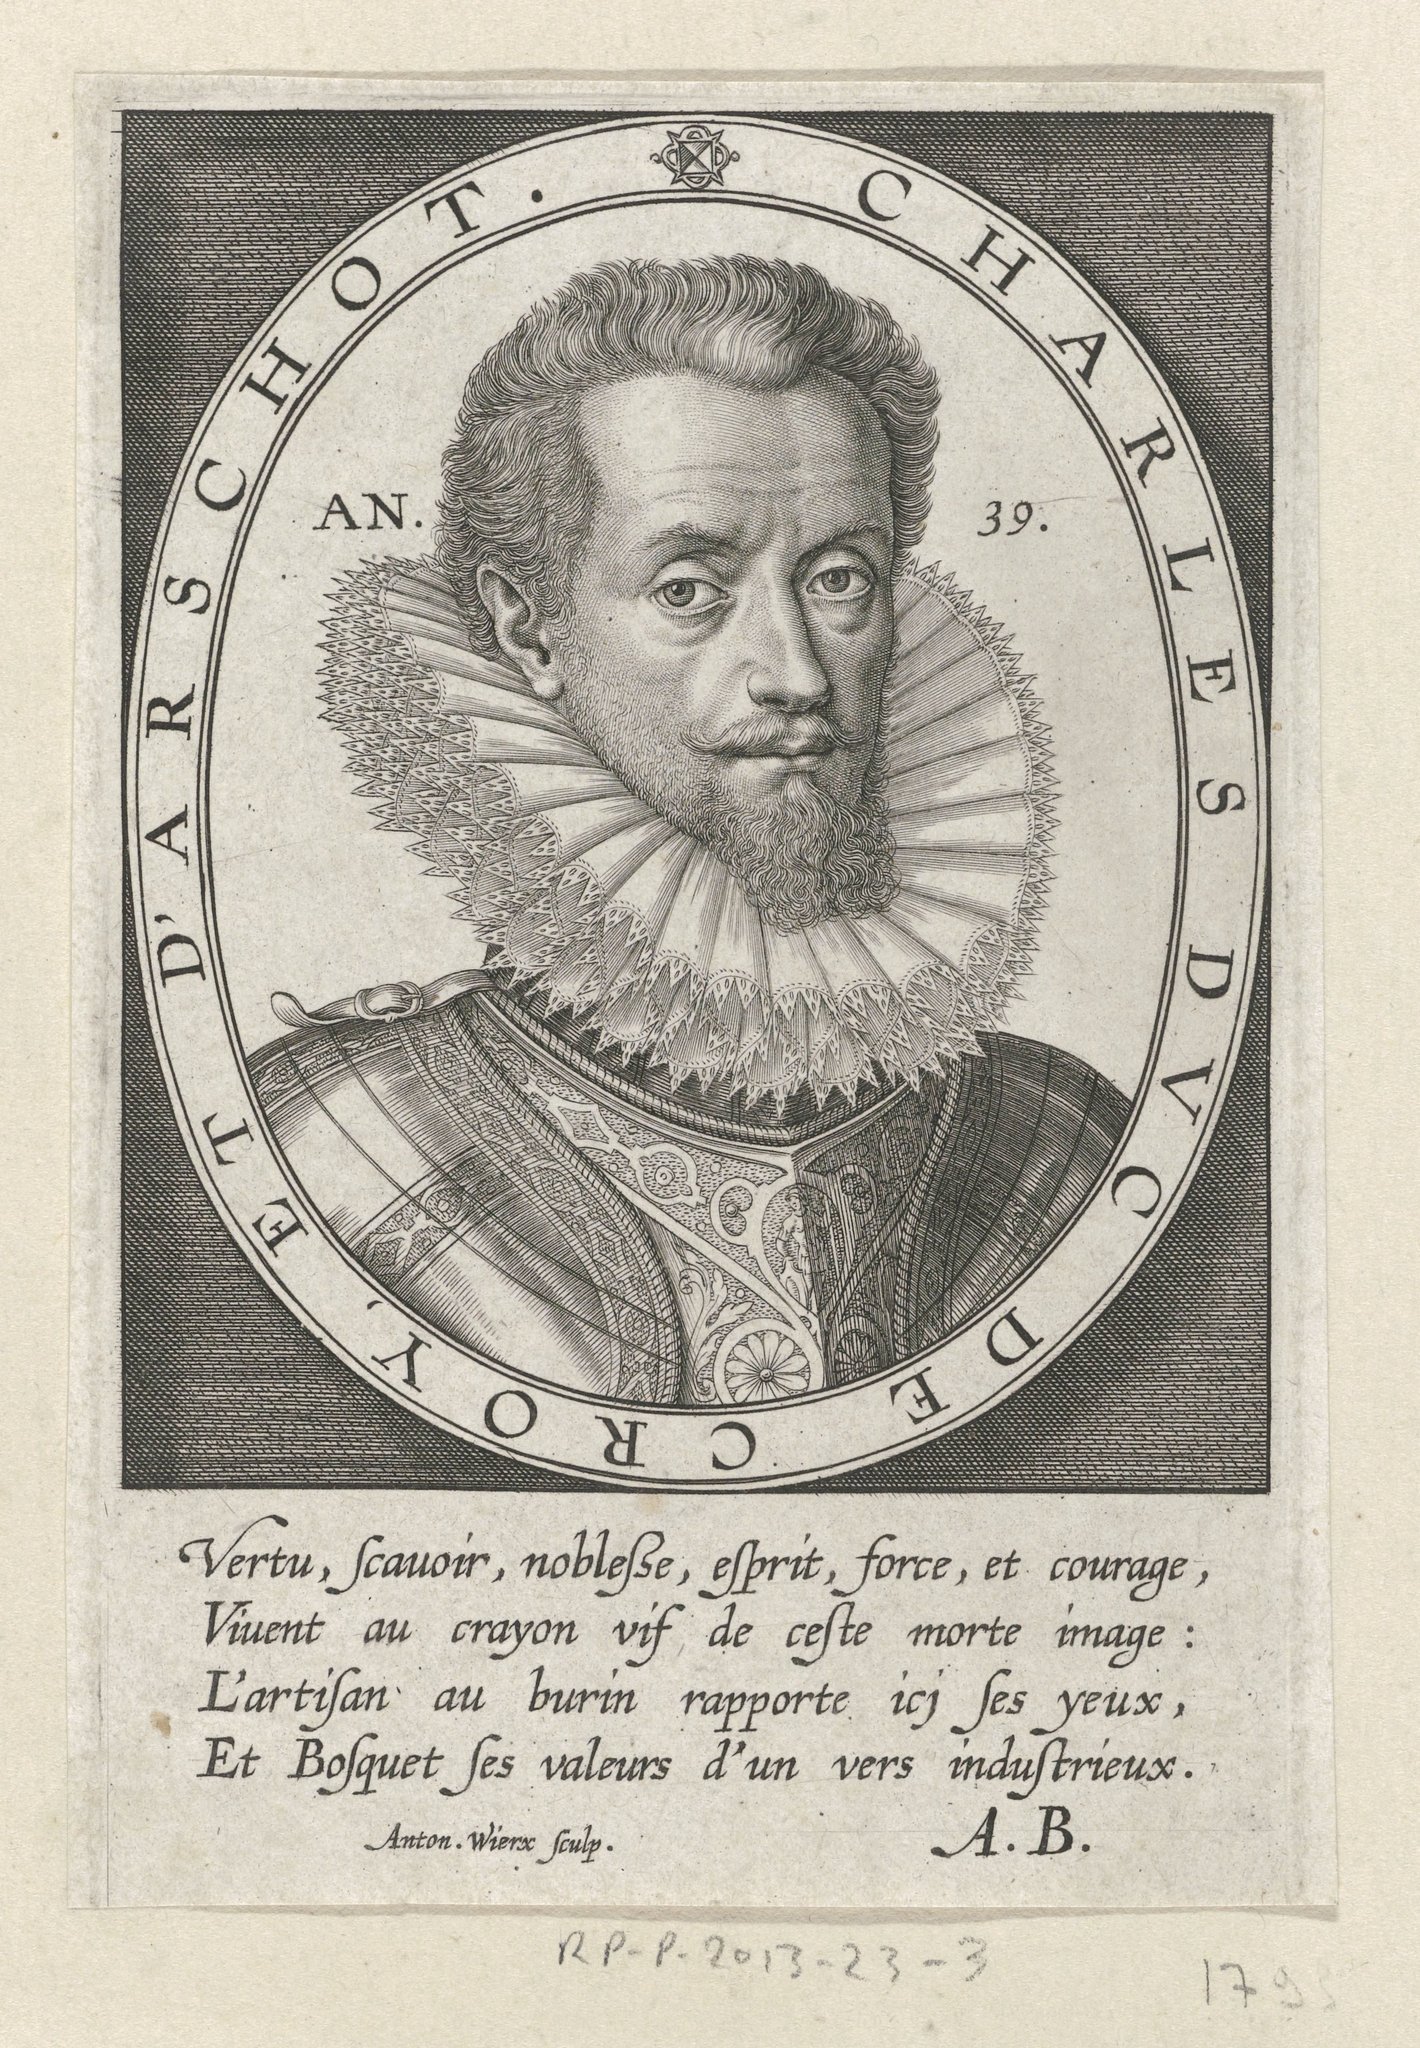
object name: print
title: Portret van Charles de Croy, Hertog van Aarschot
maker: antonie wierix (ii)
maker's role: draughtsman, print maker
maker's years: 1555-1604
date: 1599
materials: paper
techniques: engraving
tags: earl, karel iii van croÿ (hertog van aarschot), historical persons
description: Eén van drie portretten gemonteerd op een 18de-eeuws(?) albumblad.